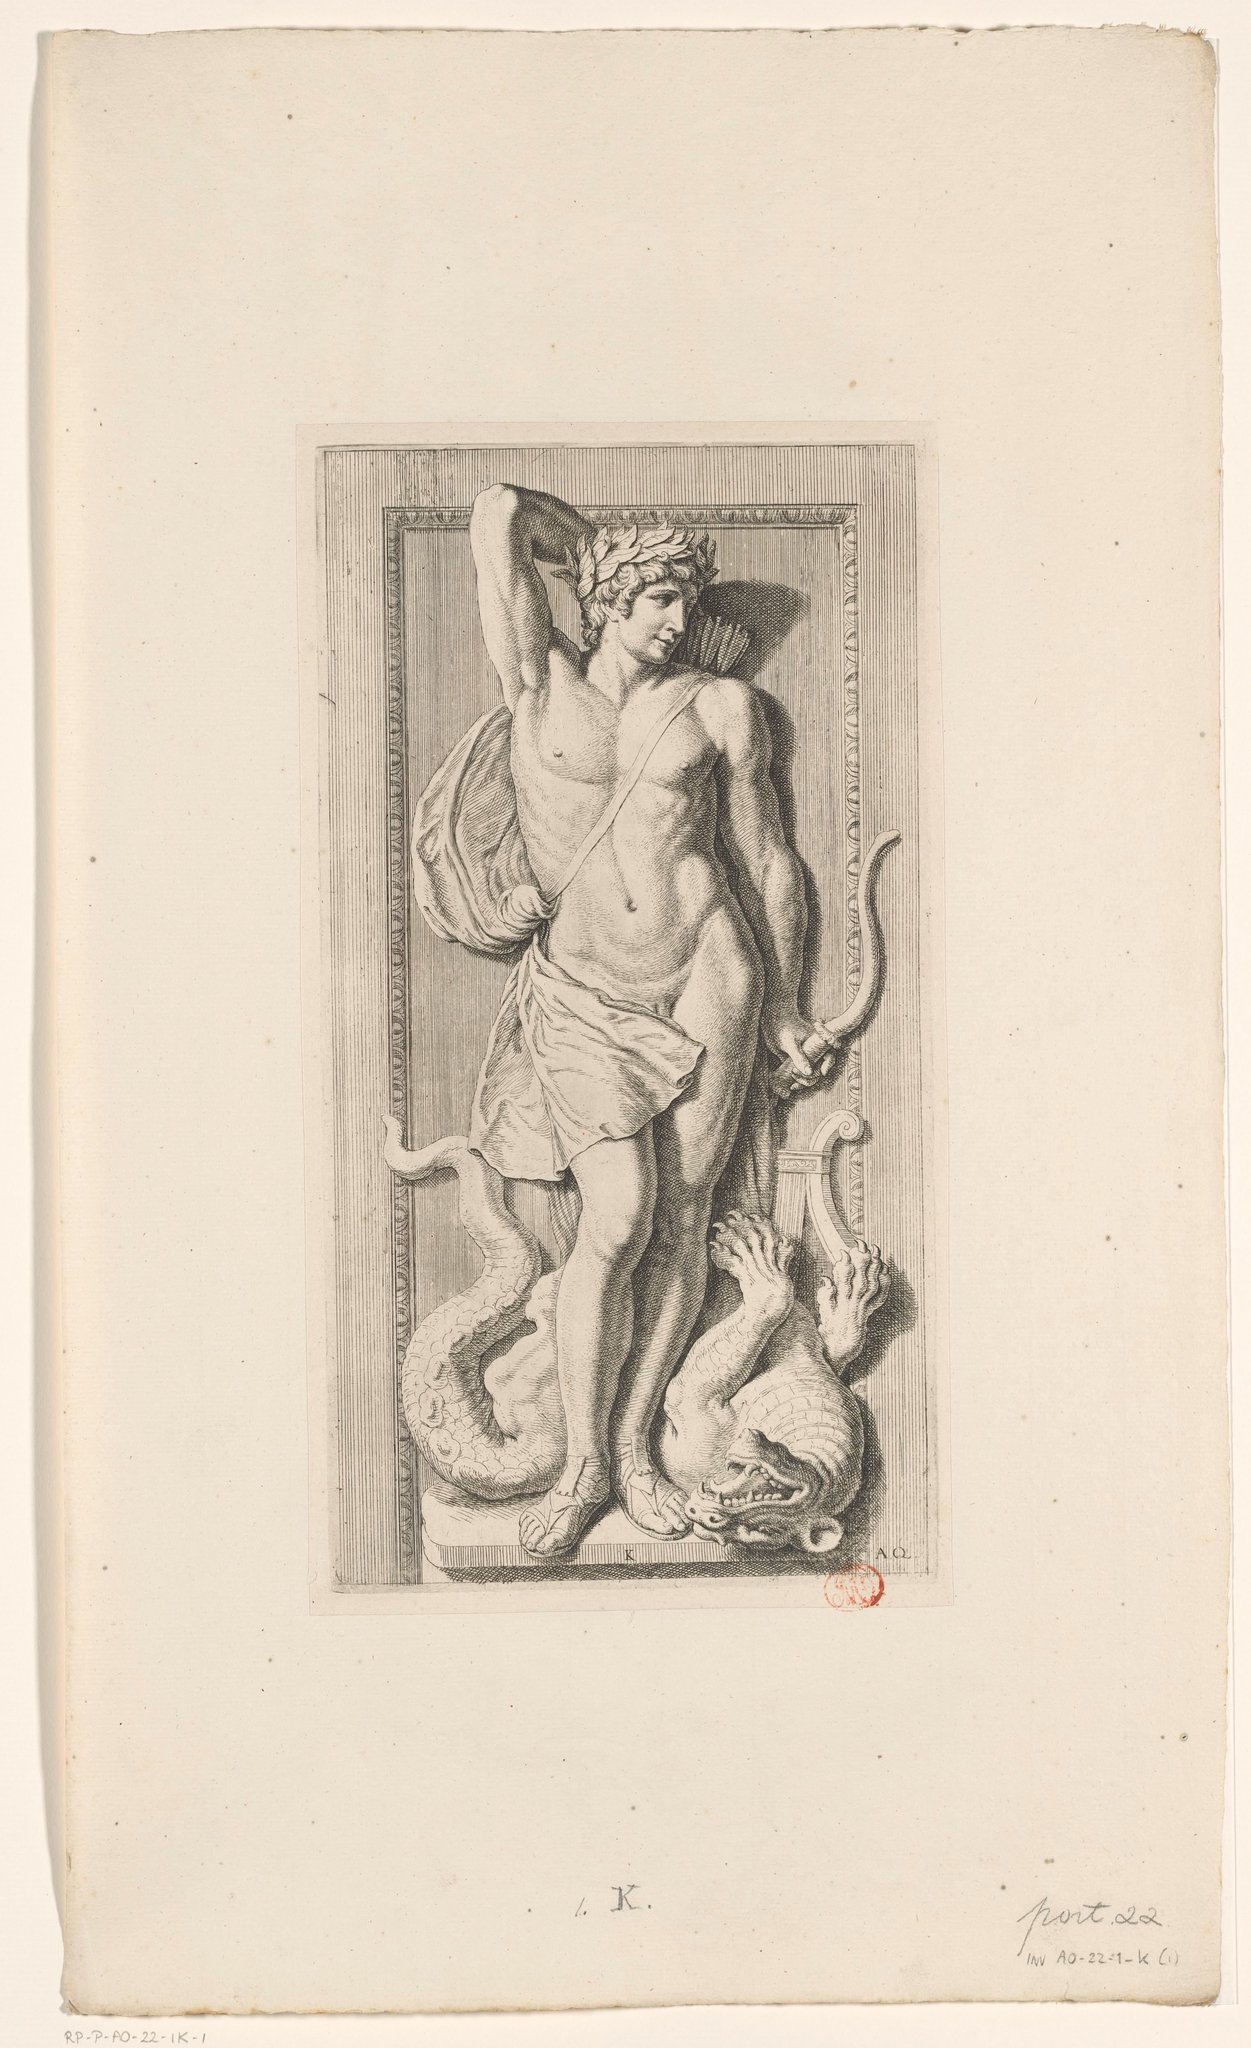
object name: book illustration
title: Beeld van Apollo in de westelijke galerij van het Stadhuis op de Dam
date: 1655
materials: paper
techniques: engraving, etching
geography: amsterdam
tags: (story of) apollo (phoebus), attributes of apollo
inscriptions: collector's mark: Lugt 195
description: Prent gebruikt in: Prima pars. Praecipuarum effigierum ac ornamentorum, amplissimae Curiae Amstelrodamensis (…) / Het eerste deel. Van de voornaemste Statuen ende Ciraten, vant konstijck Stadhuys van Amstelredam, tmeeste in marmer gemaeckt, door Artus Quellinus, Beelthouwer der voorseyde Stadt / La Premier Partie. De plusieurs Figures et ornements, de la Maison de Ville d'Amsterdam (…). Amsterdam: Artus Quellinus (I), 1655. Zie RP-P-AO-22-1-1 voor bijhorende titelpagina. Zie RP-P-AO-22-1-2 voor bijhorend register. Zie RP-P-AO-22-1A, RP-P-AO-22-1B, RP-P-AO-22-1C, RP-P-AO-22-1D-1, RP-P-AO-22-1D-2, RP-P-AO-22-1E, RP-P-AO-22-1F, RP-P-AO-22-1G, RP-P-AO-22-1H, RP-P-AO-22-1I, RP-P-AO-22-1K-2, RP-P-AO-22-1K-3, RP-P-AO-22-1K-4, RP-P-AO-22-1K-5, RP-P-AO-22-1L-1, RP-P-AO-22-1L-2, RP-P-AO-22-1M-1, RP-P-AO-22-1M-2, RP-P-AO-22-1N-1, RP-P-AO-22-1N-2, RP-P-AO-22-1N-3, RP-P-AO-22-1N-4, RP-P-AO-22-1N-5, RP-P-AO-22-1O-1, RP-P-AO-22-1O-2, RP-P-AO-22-1O-3, RP-P-AO-22-1O-4, RP-P-AO-22-1P-1, RP-P-AO-22-1P-2, RP-P-AO-22-1P-3, RP-P-AO-22-1P-4, RP-P-AO-22-1Q-1, RP-P-AO-22-1Q-2, RP-P-AO-22-1Q-3, RP-P-AO-22-1Q-4, RP-P-AO-22-1R-1, RP-P-AO-22-1R-2, RP-P-AO-22-1R-3, RP-P-AO-22-1R-4, RP-P-AO-22-1R-5, RP-P-AO-22-1S-1, RP-P-AO-22-1S-2, RP-P-AO-22-1S-3, RP-P-AO-22-1S-4, RP-P-AO-22-1S-5, RP-P-AO-22-1T-1 en RP-P-AO-22-1T-2 voor andere prenten uit deze publicatie. Zelfde staat van prent ook gebruikt in: Prima pars. Praecipuarum effigierum ac ornamentorum, amplissimae Curiae Amstelrodamensis (…) / Het eerste deel. Van de voornaemste Statuen ende Ciraten, vant konstijck Stadhuys van Amstelredam, tmeeste in marmer gemaeckt, door Artus Quellinus, Beelthouwer der voorseyde Stadt / La Premier Partie. De plusieurs Figures et ornements, de la Maison de Ville d'Amsterdam (…). Amsterdam: Frederik de Wit, 1665. Latere staat van prent ook gebruikt in: Architecture peinture et sculpture de la Maison de Ville d'Amsterdam, representee en CIX. figures en taille-douce (…). Amsterdam: David Mortier, 1719. En in: Architecture peinture et sculpture de la Maison de Ville d'Amsterdam, representee en CIX. figures en taille-douce (…). Amsterdam: Gerard Valck, 1719. En in: Bouw schilder en beeldhouwkonst, van het Stadhuis te Amsteldam, vertoont in CIX figuuren (…). Amsterdam: Covens & Mortier & Covens Jr., s.a. (1774-1783). Zie BK-AM-51-19 voor een model van het beeld.